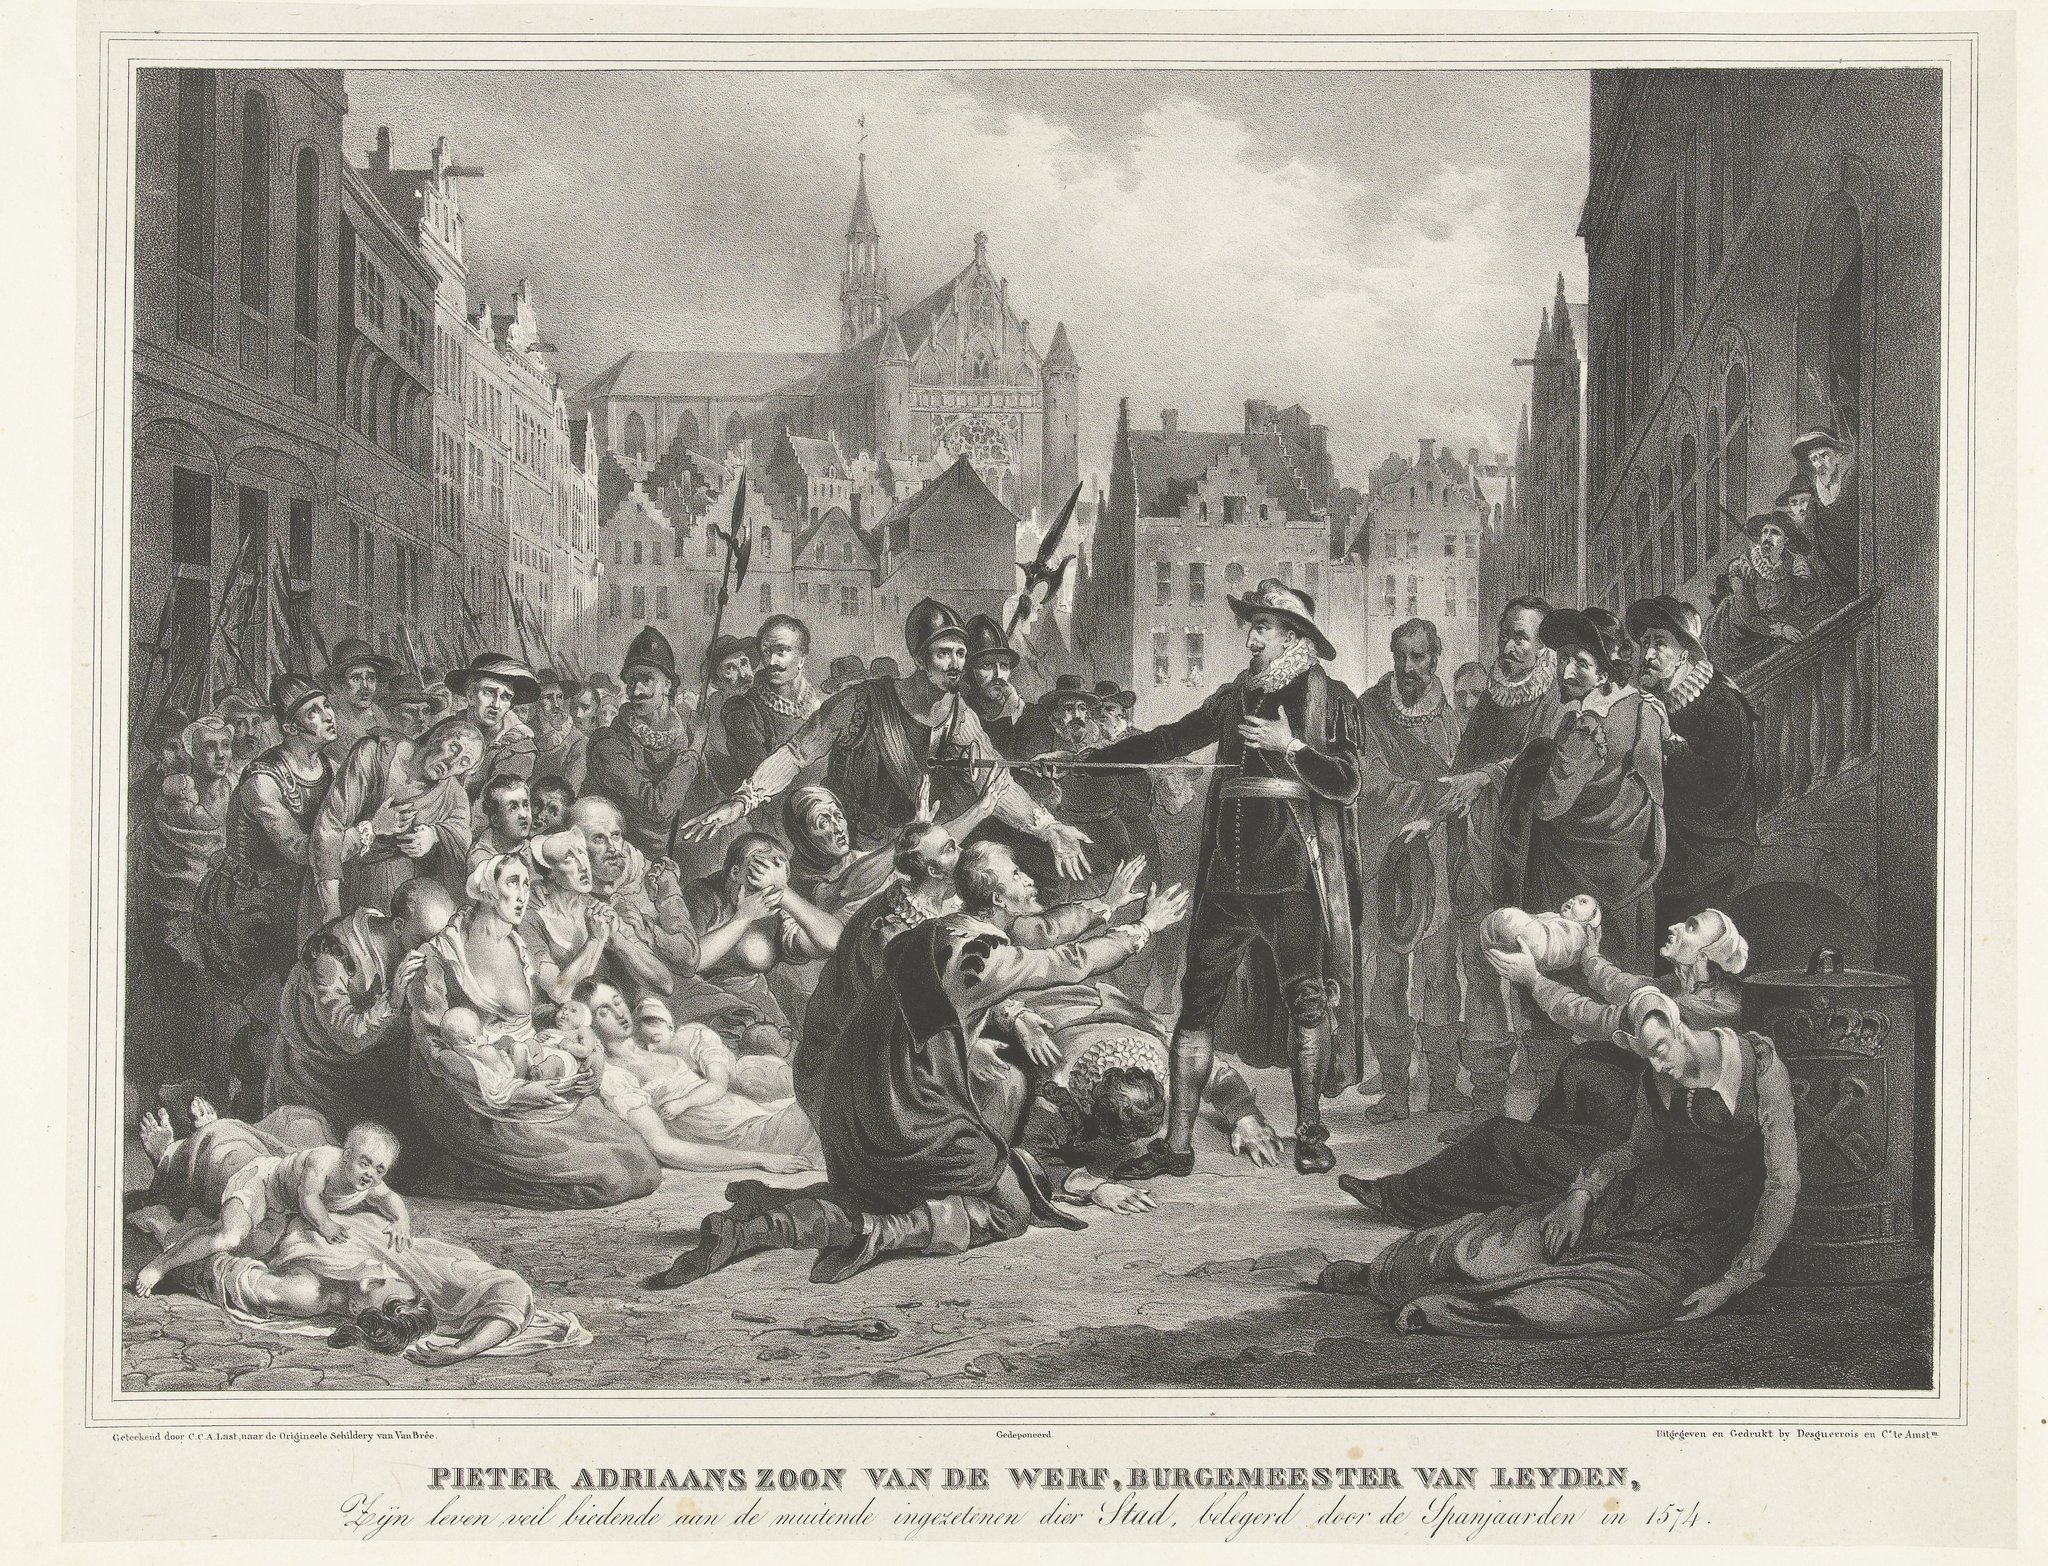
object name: print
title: Pieter Adriaanszoon van de Werf, burgemeester van Leyden, Zijn leven veil biedende aan de muitende ingezetenen dier Stad, belegerd door de Spanjaarden in 1574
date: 1818-1876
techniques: printmaking, lithograph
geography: amsterdam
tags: mayor, leiden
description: De zelfopoffering van burgemeester Pieter van der Werff, tijdens het beleg van Leiden, 1574. Van der Werff staande op straat voor knielende en op straat zittende wanhopige Leidenaren en biedt hen zijn zwaard en lichaam aan.